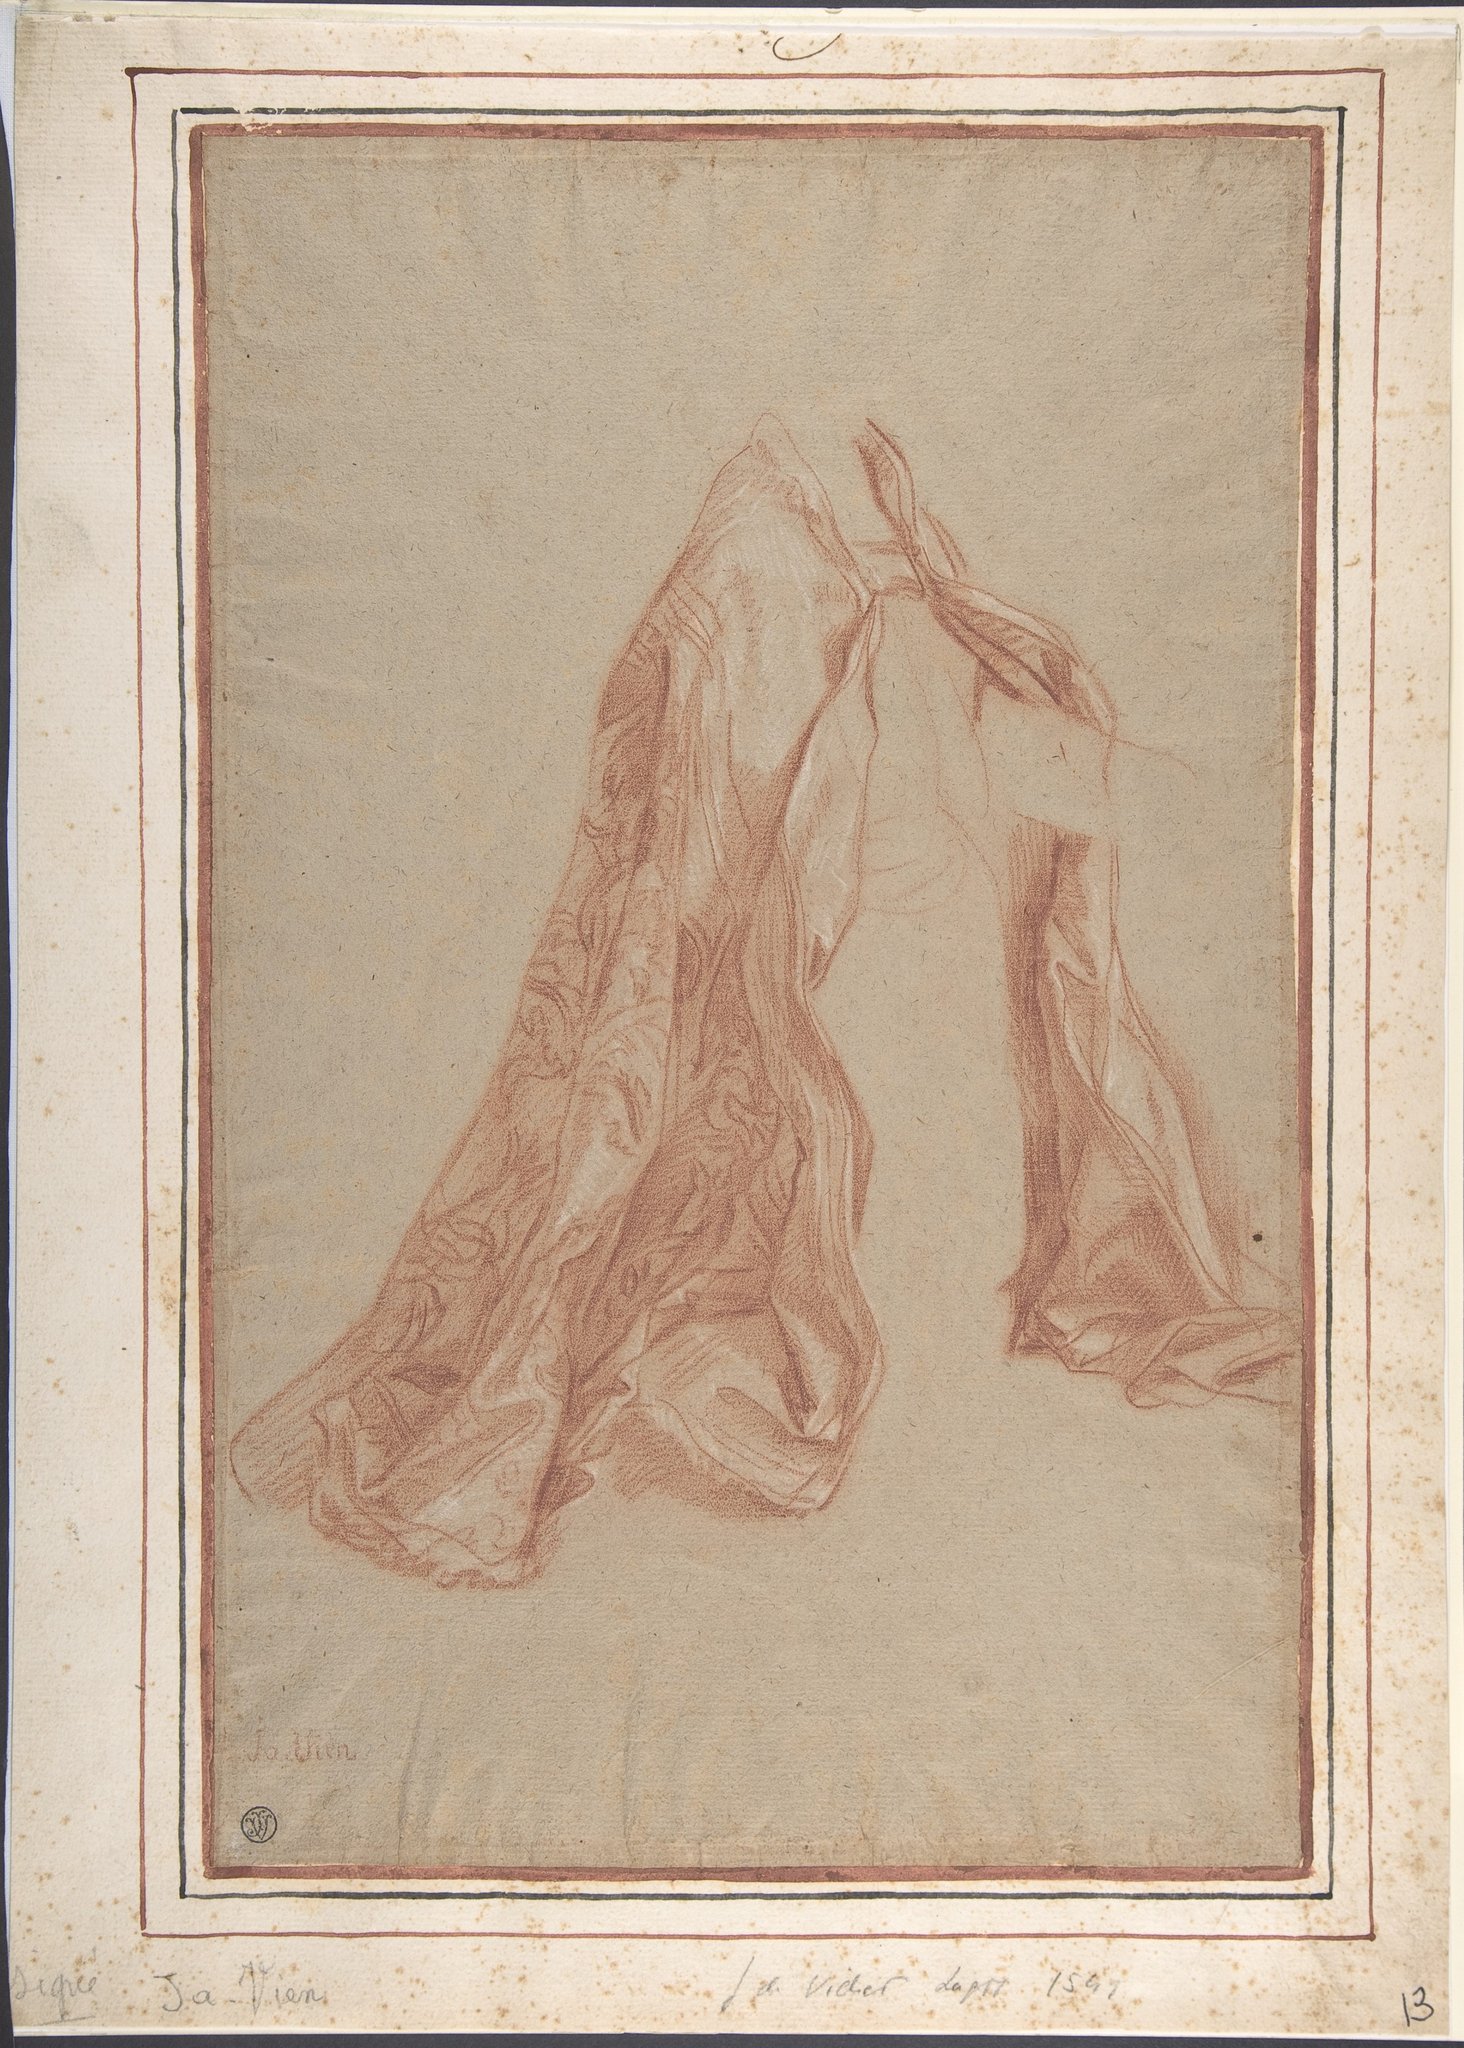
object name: drawing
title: Kneeling Figure Wearing a Cope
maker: joseph marie vien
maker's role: artist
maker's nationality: french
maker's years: 1716-1809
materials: chalk, paper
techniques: heightening